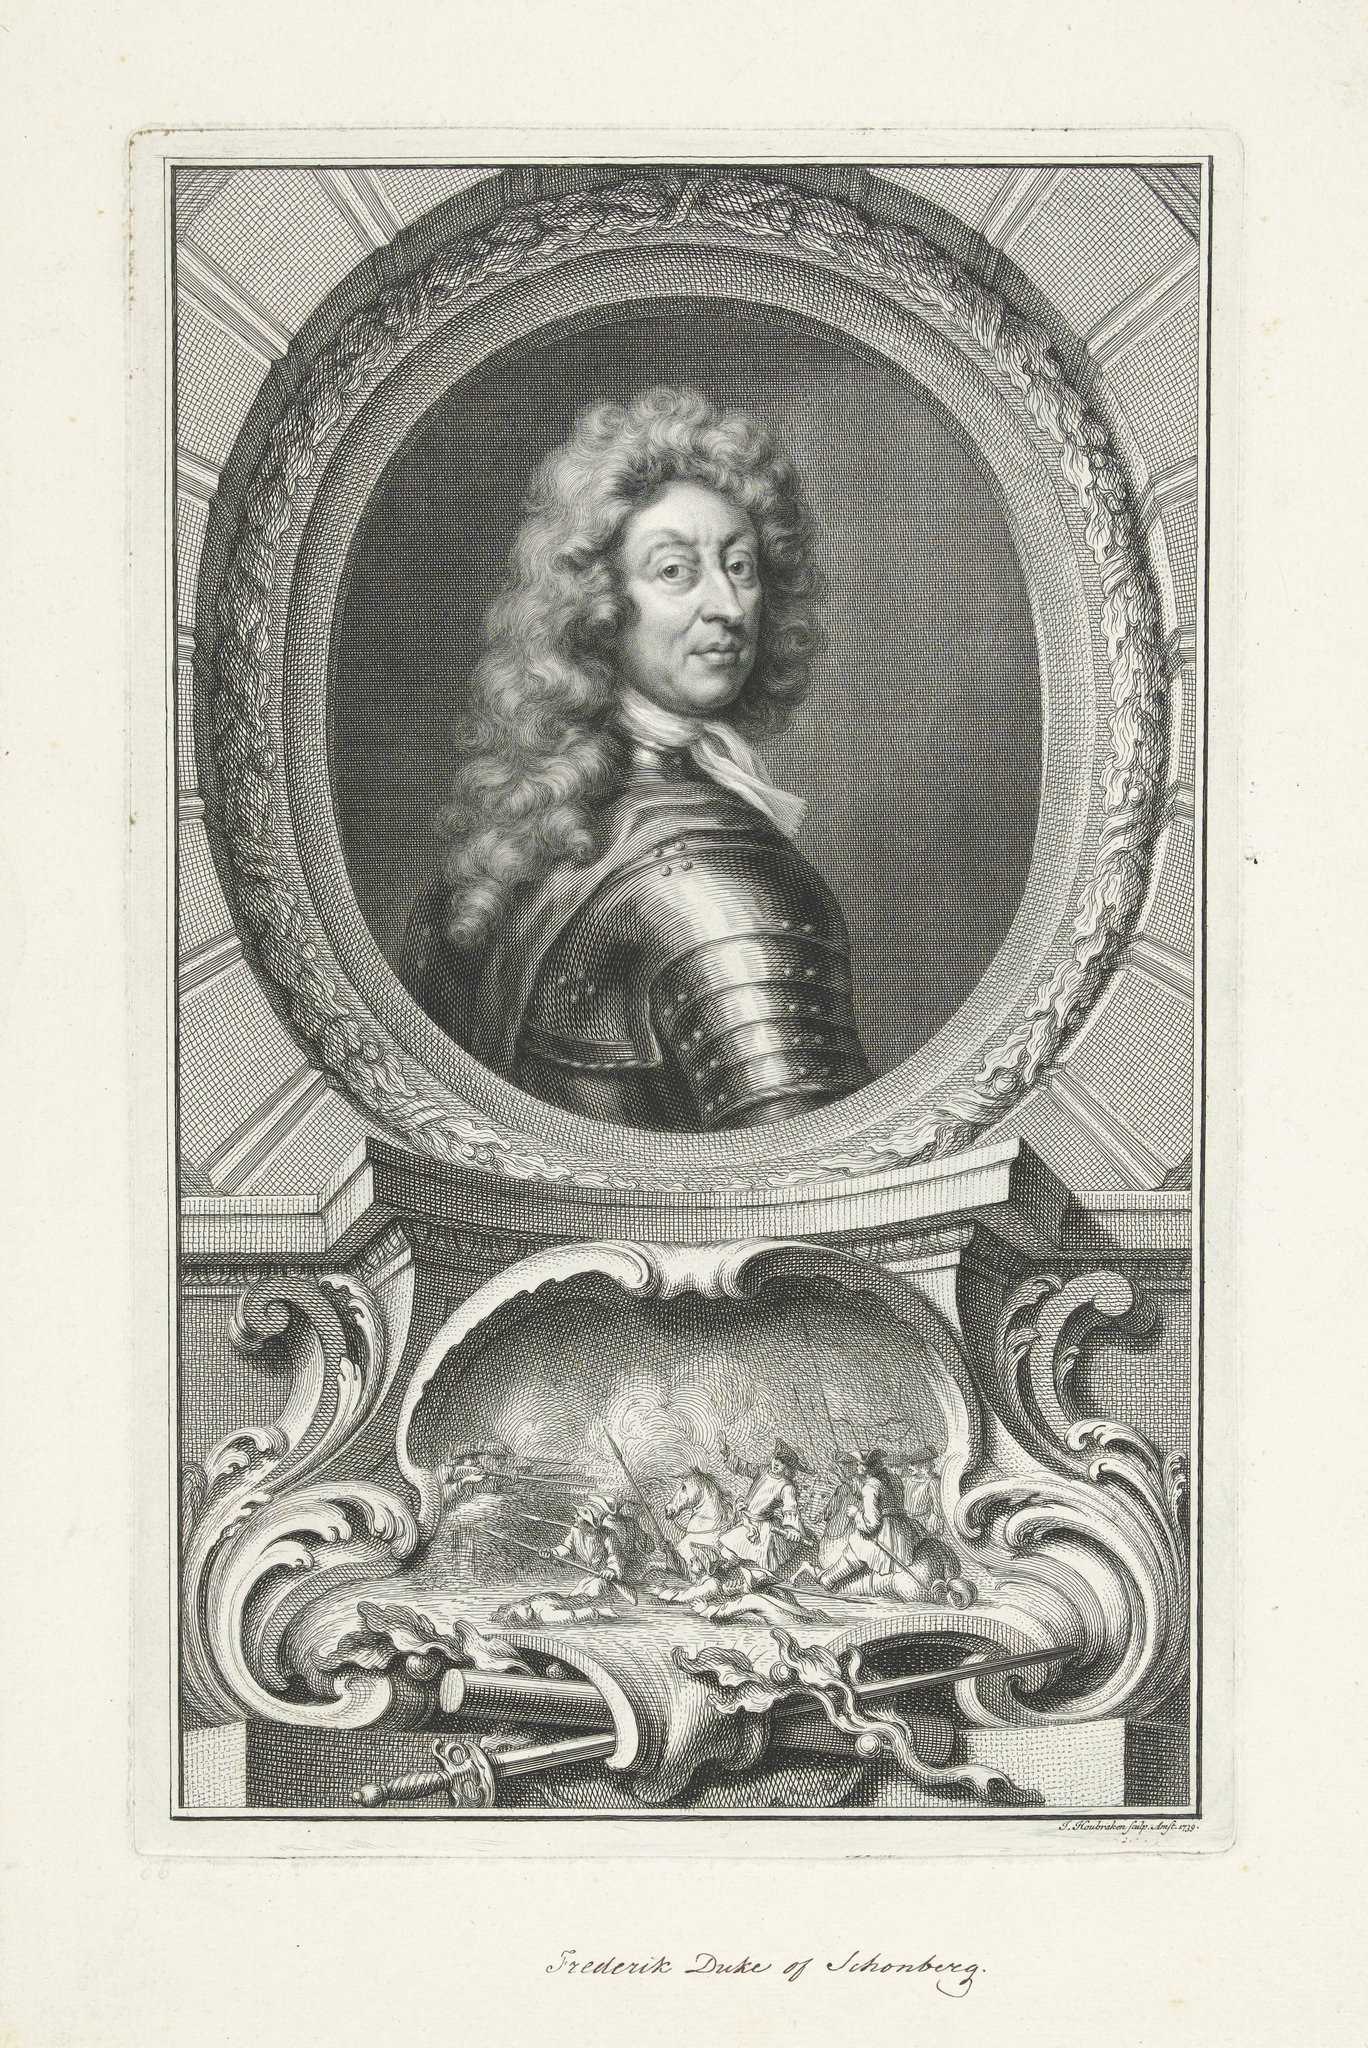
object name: print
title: Portret van Friedrich Arnaud hertog van Schomberg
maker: jacob houbraken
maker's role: draughtsman, print maker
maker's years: 1698-1780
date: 1737-1739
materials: paper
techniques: engraving, etching, pen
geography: amsterdam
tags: heidelberg, boyne battlesite, veldheer, frederik van schomberg (hertog), drogheda, slag aan de boyne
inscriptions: collector's mark: Lugt 240, name: ‘Frederik Duke of Schonberg’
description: Prent ook gebruikt in: Thomas Birch. The heads of illustrious persons of Great Britain : engraved by Houbraken, and Vertue, with their lives and characters. London: John en Paul Knapton, 1743-1751.